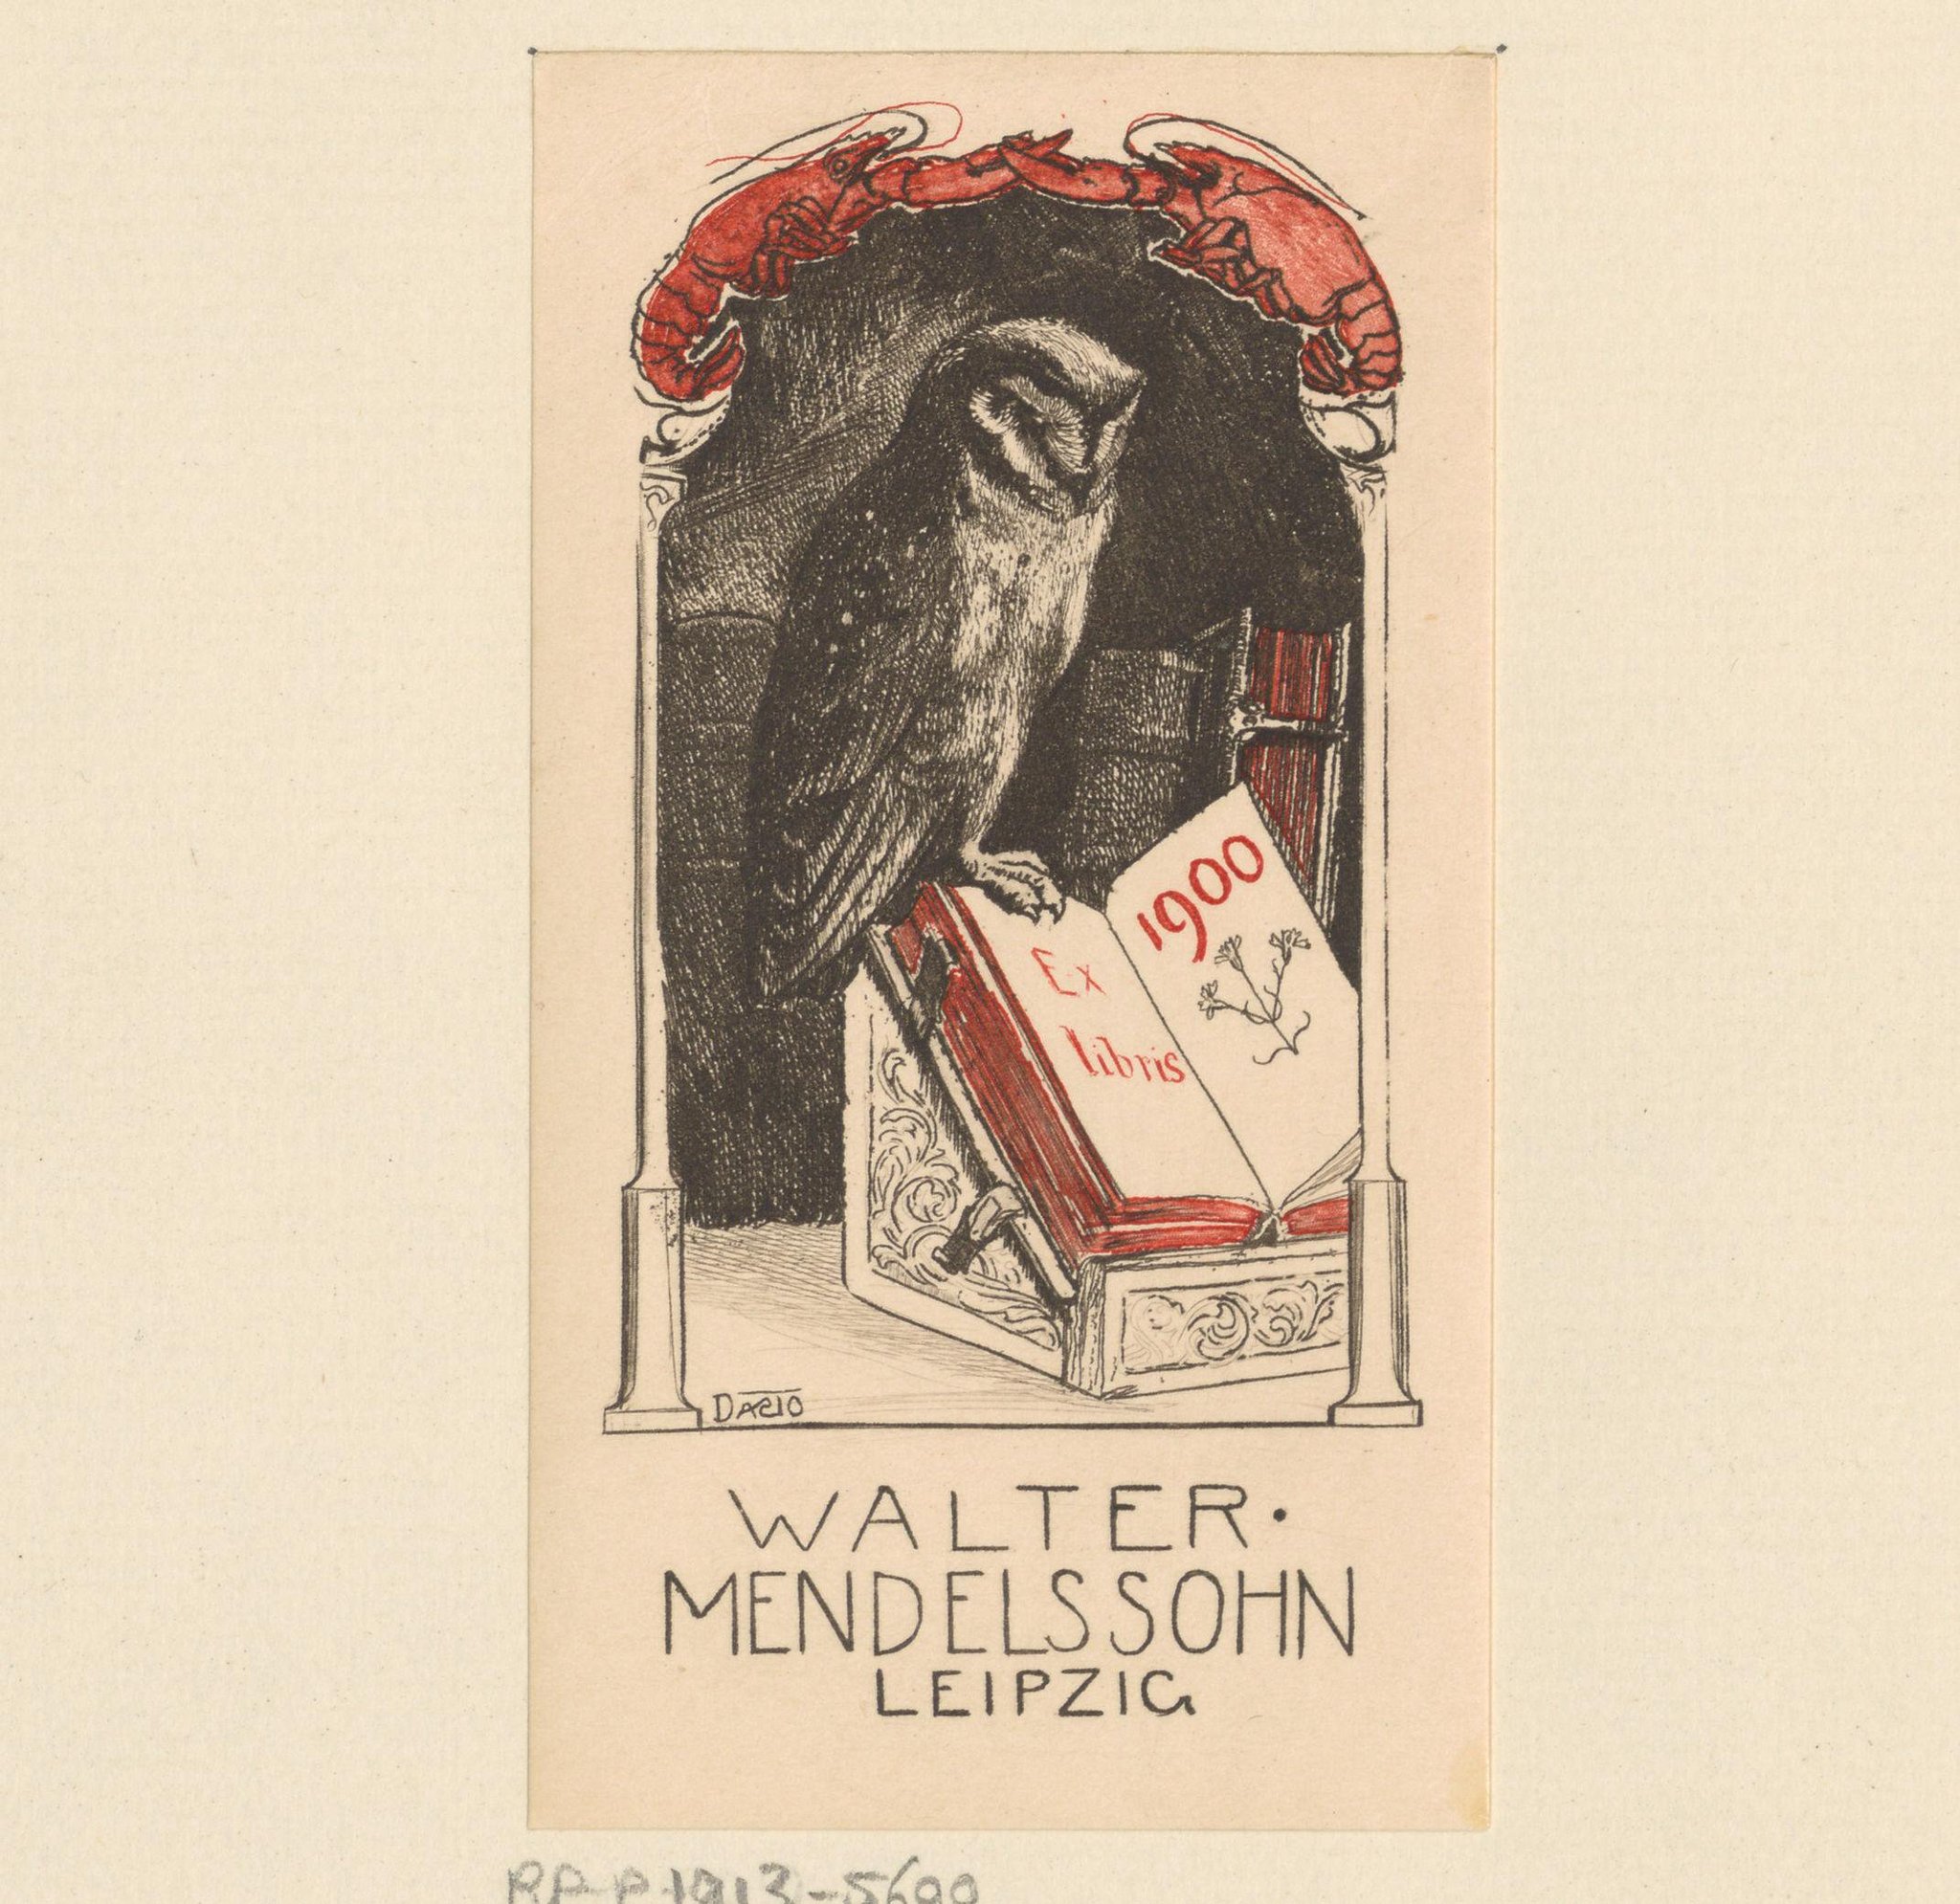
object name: bookplate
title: Ex libris van Walter Mendelssohn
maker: maximilian dasio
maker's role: painter, print maker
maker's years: 1865-1954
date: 1900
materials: paper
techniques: etching, roulette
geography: germany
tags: book, owls, crustaceans: lobster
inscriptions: collector's mark: Lugt 2233, collector's mark: Lugt 2760